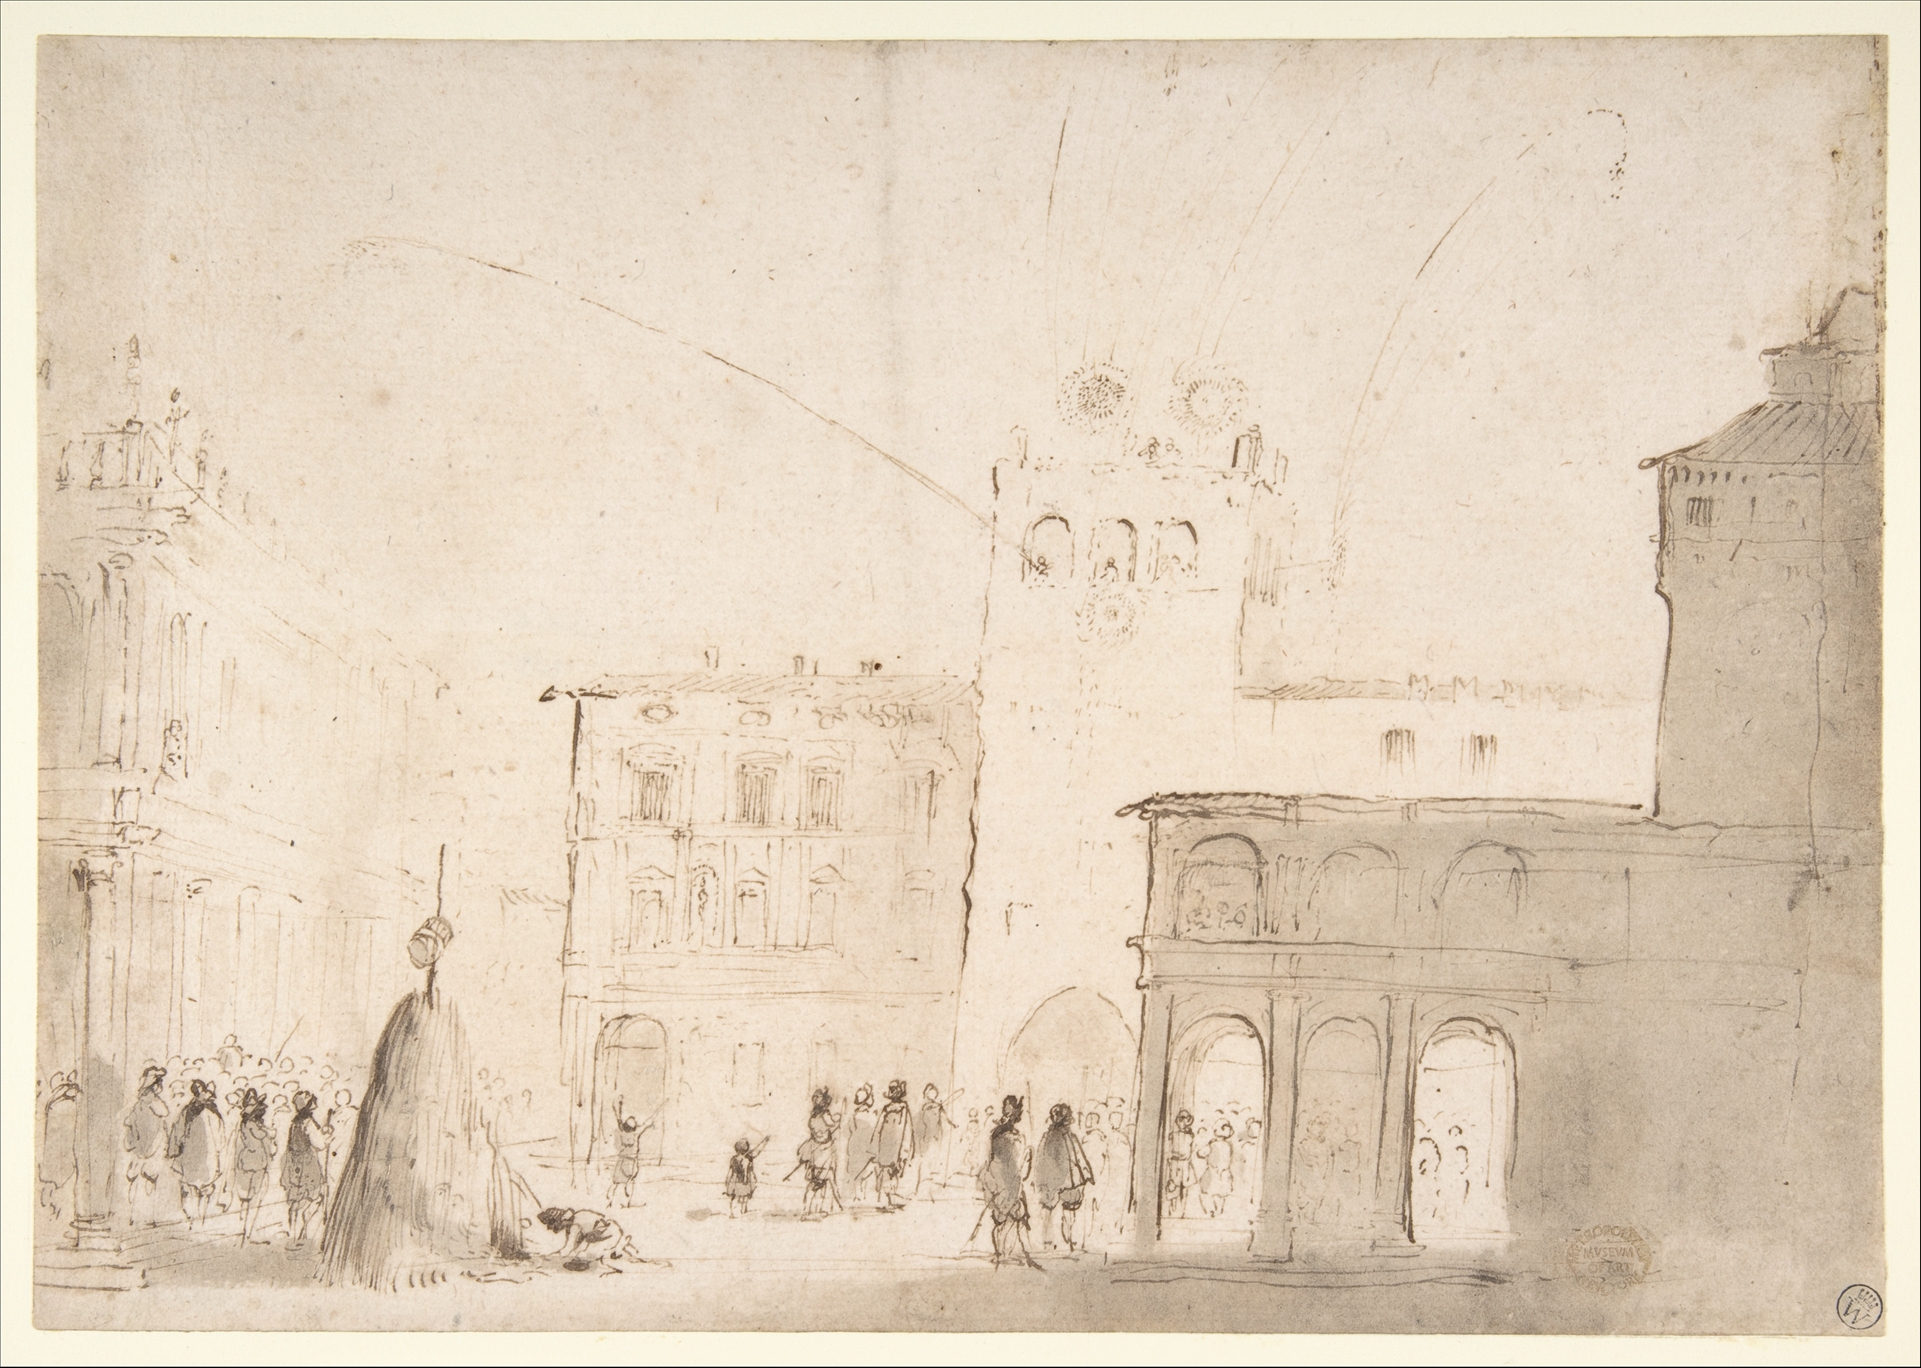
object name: drawing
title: Fireworks in a Piazza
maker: guercino (giovanni francesco barbieri)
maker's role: artist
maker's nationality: italian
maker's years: 1591-1666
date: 1618-1623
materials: ink, drawing material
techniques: brush, pen, wash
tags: buildings,fireworks